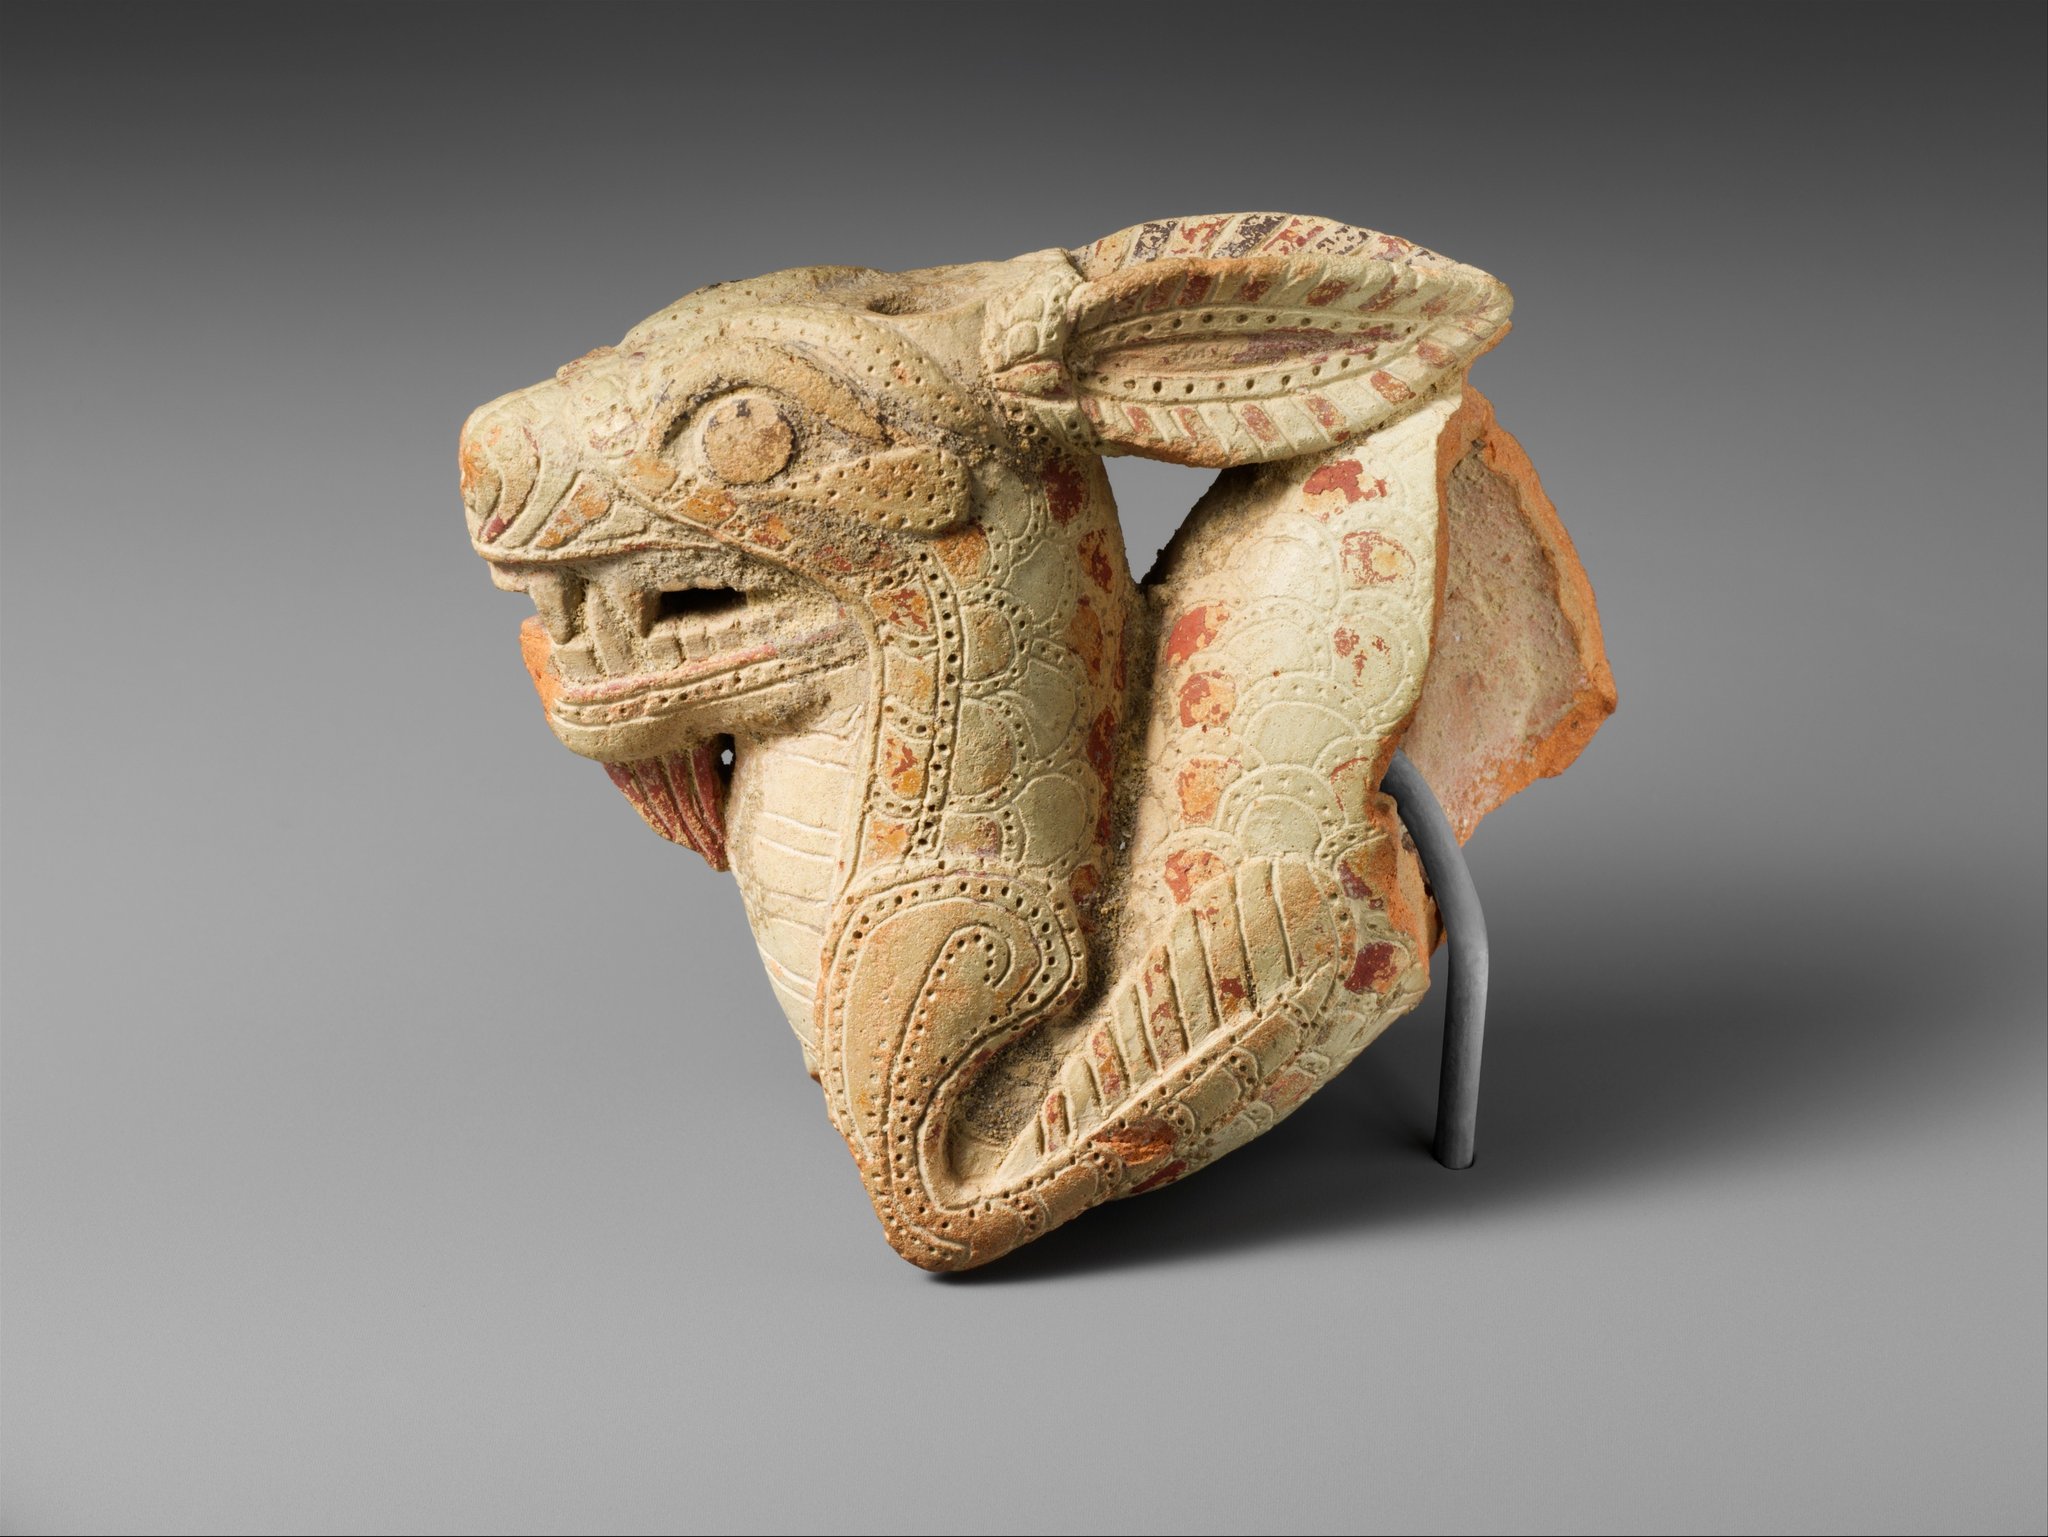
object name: vase in the form of a ketos sea monster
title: Terracotta vase in the form of a ketos (sea monster)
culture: greek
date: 650-601 BCE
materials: terracotta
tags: monsters